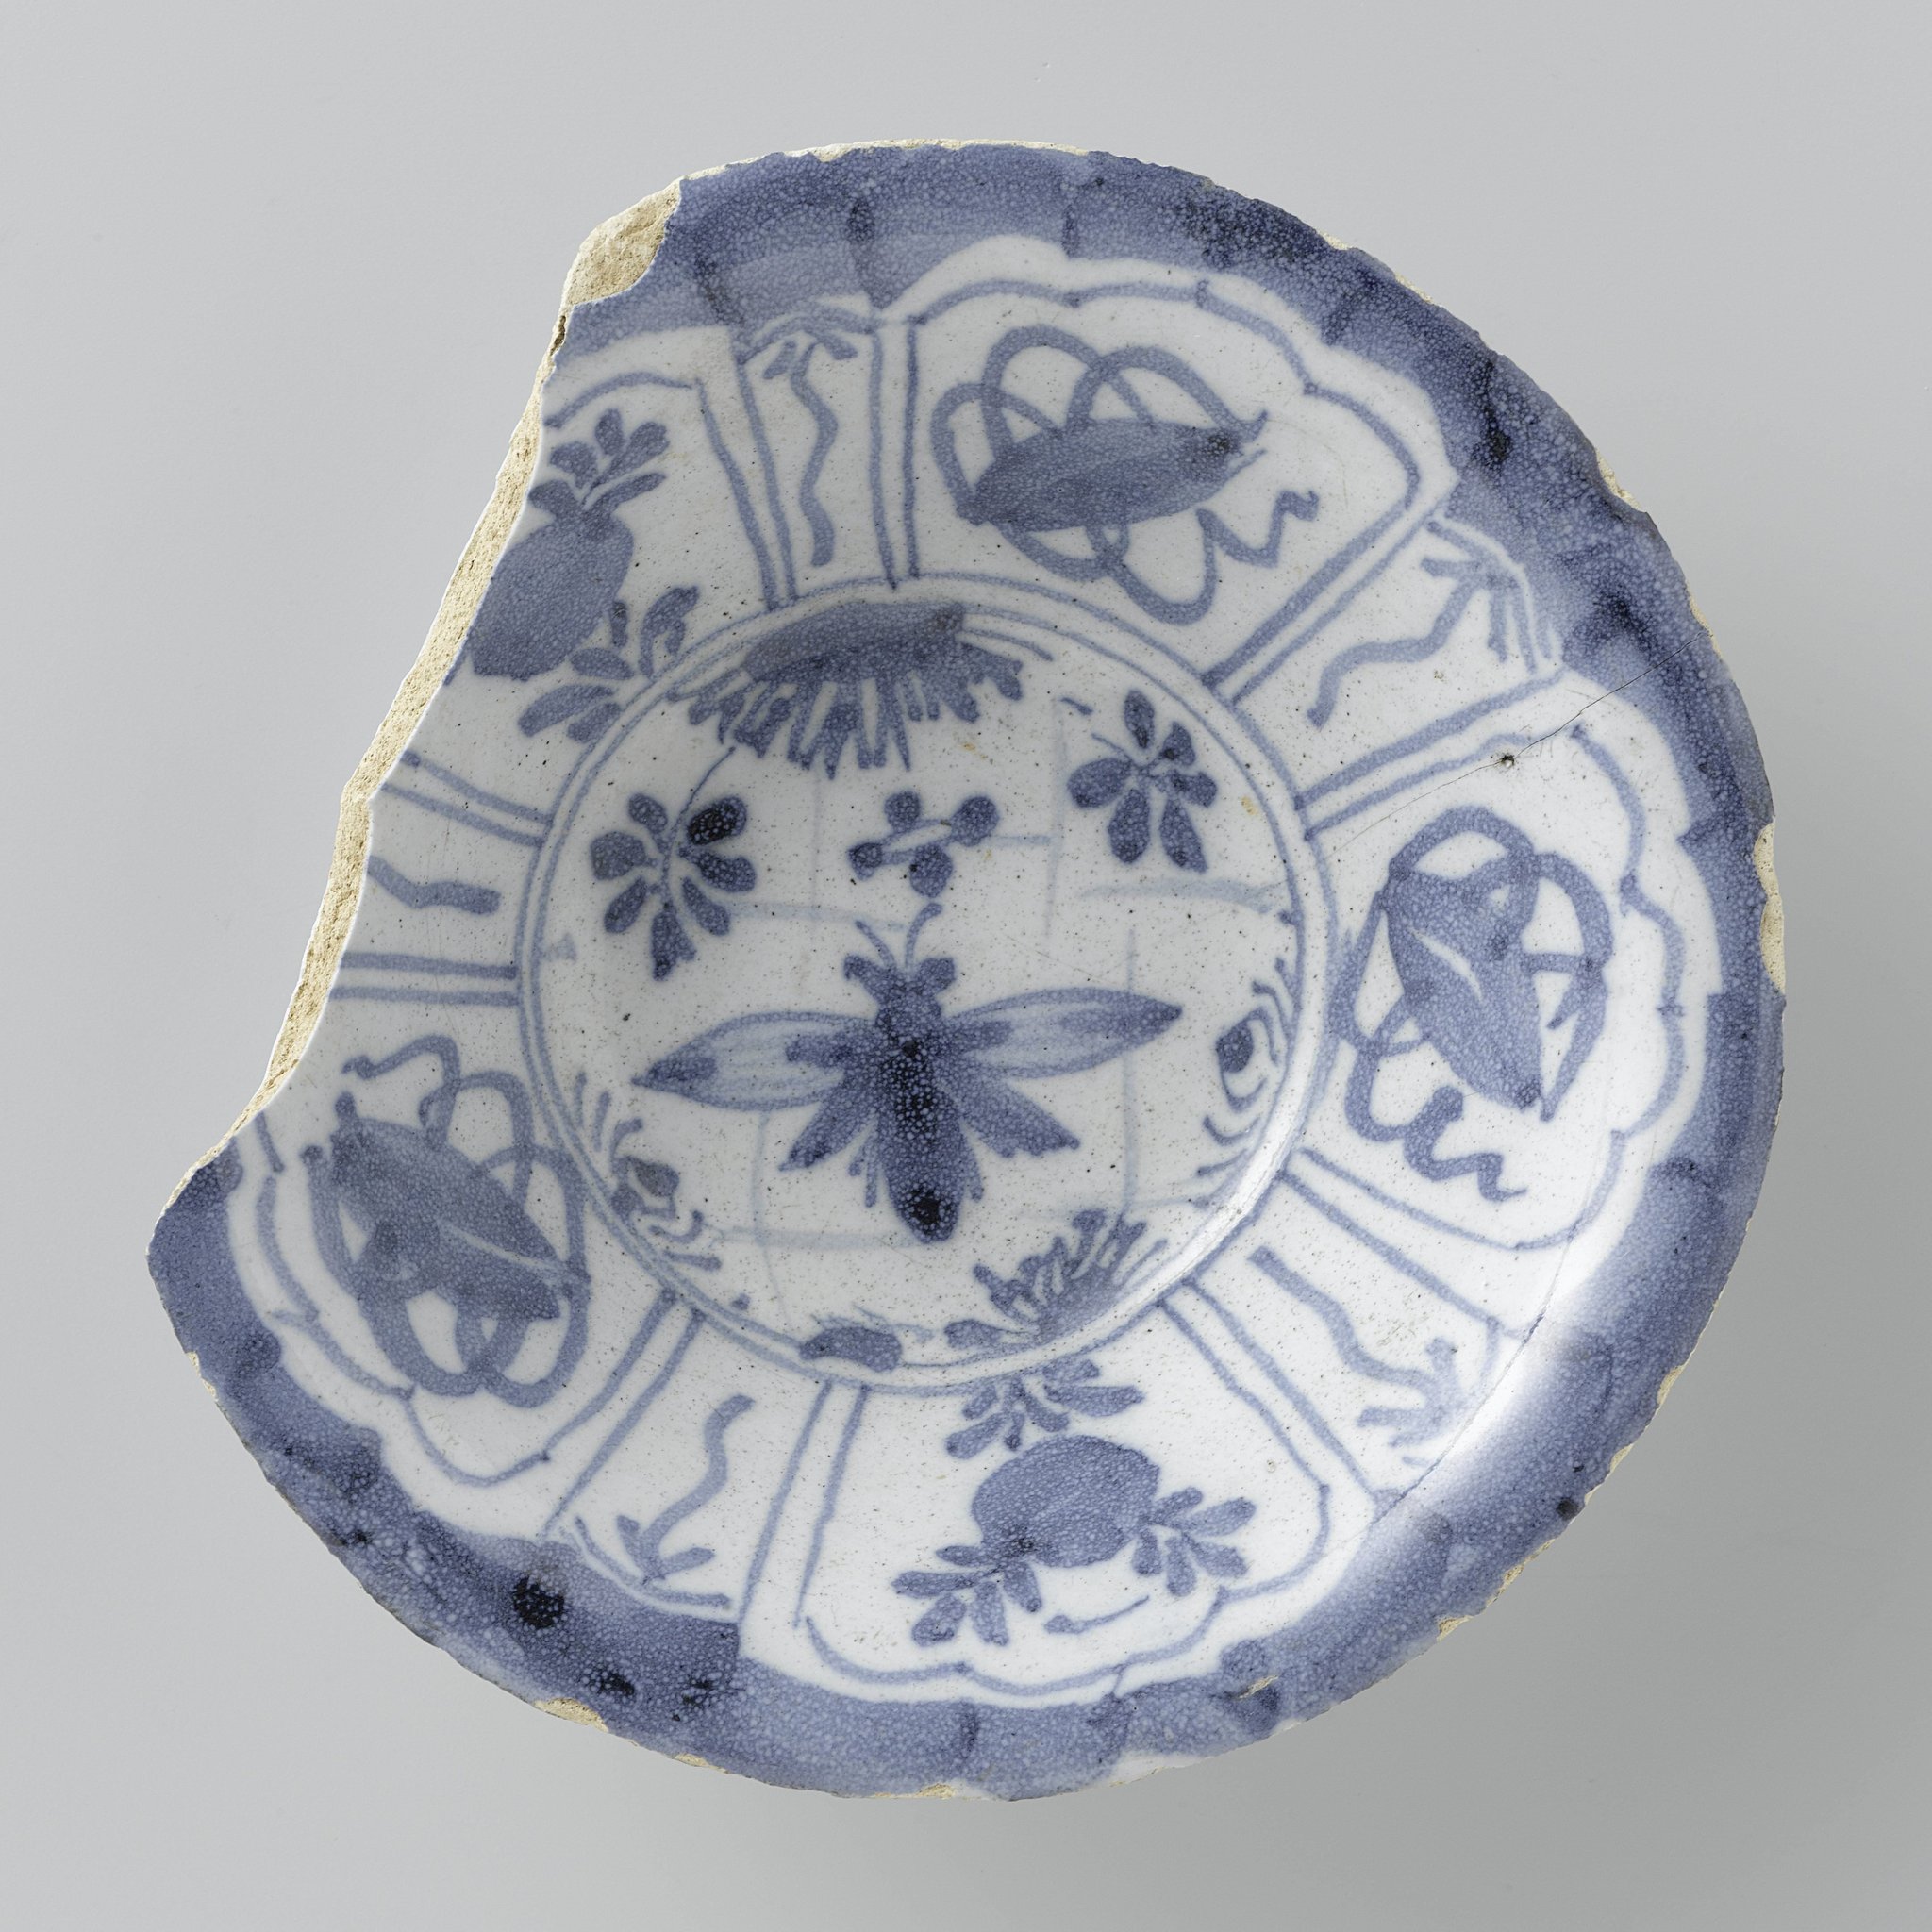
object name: fragment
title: kom van faience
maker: Anonymous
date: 1655-1675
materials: earthenware, glaze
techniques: painted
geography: delft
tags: leiden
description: kom van blauw beschilderde faience. Op de bodem aan de binnenkant is een insekt (bij ?) geschilderd en op de wand vakken (Wan-Li). De kom is een bodemvondst uit Leiden en er ontbreekt een deel van de wand.